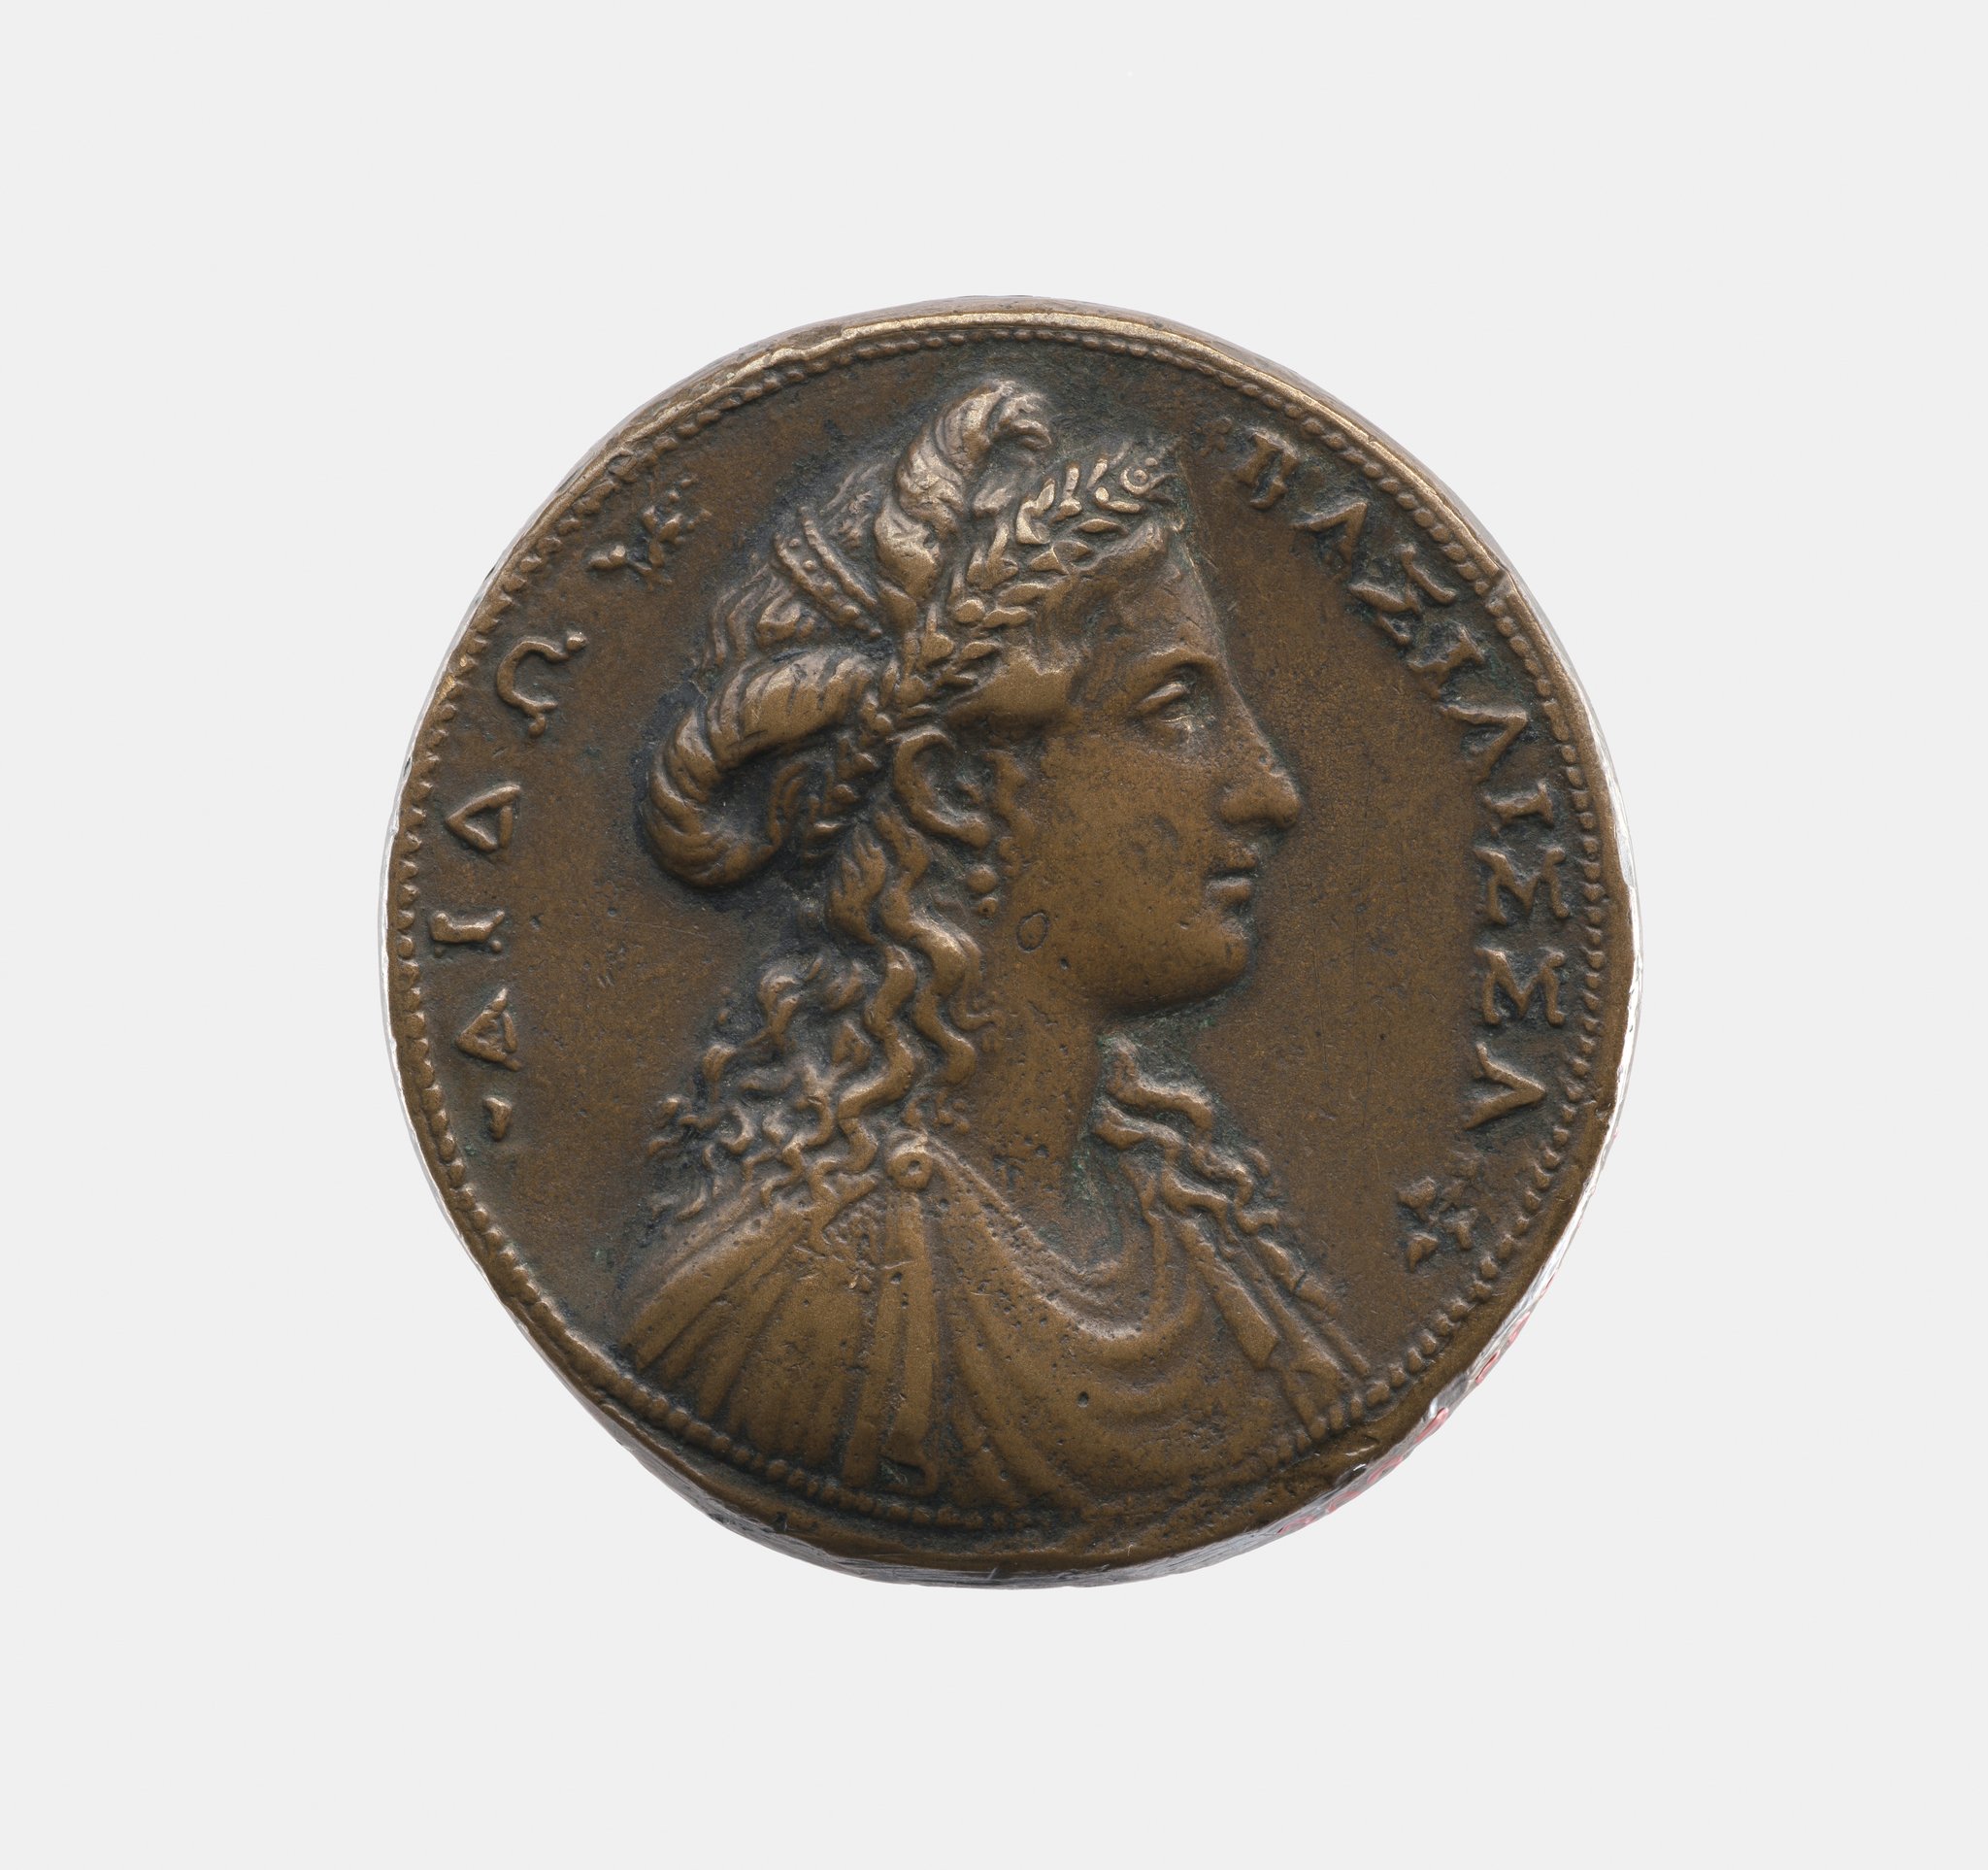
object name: medal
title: Dido, Queen of Carthage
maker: alessandro cesati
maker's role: artist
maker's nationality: italian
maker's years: 1538-1564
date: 1538-1564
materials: bronze